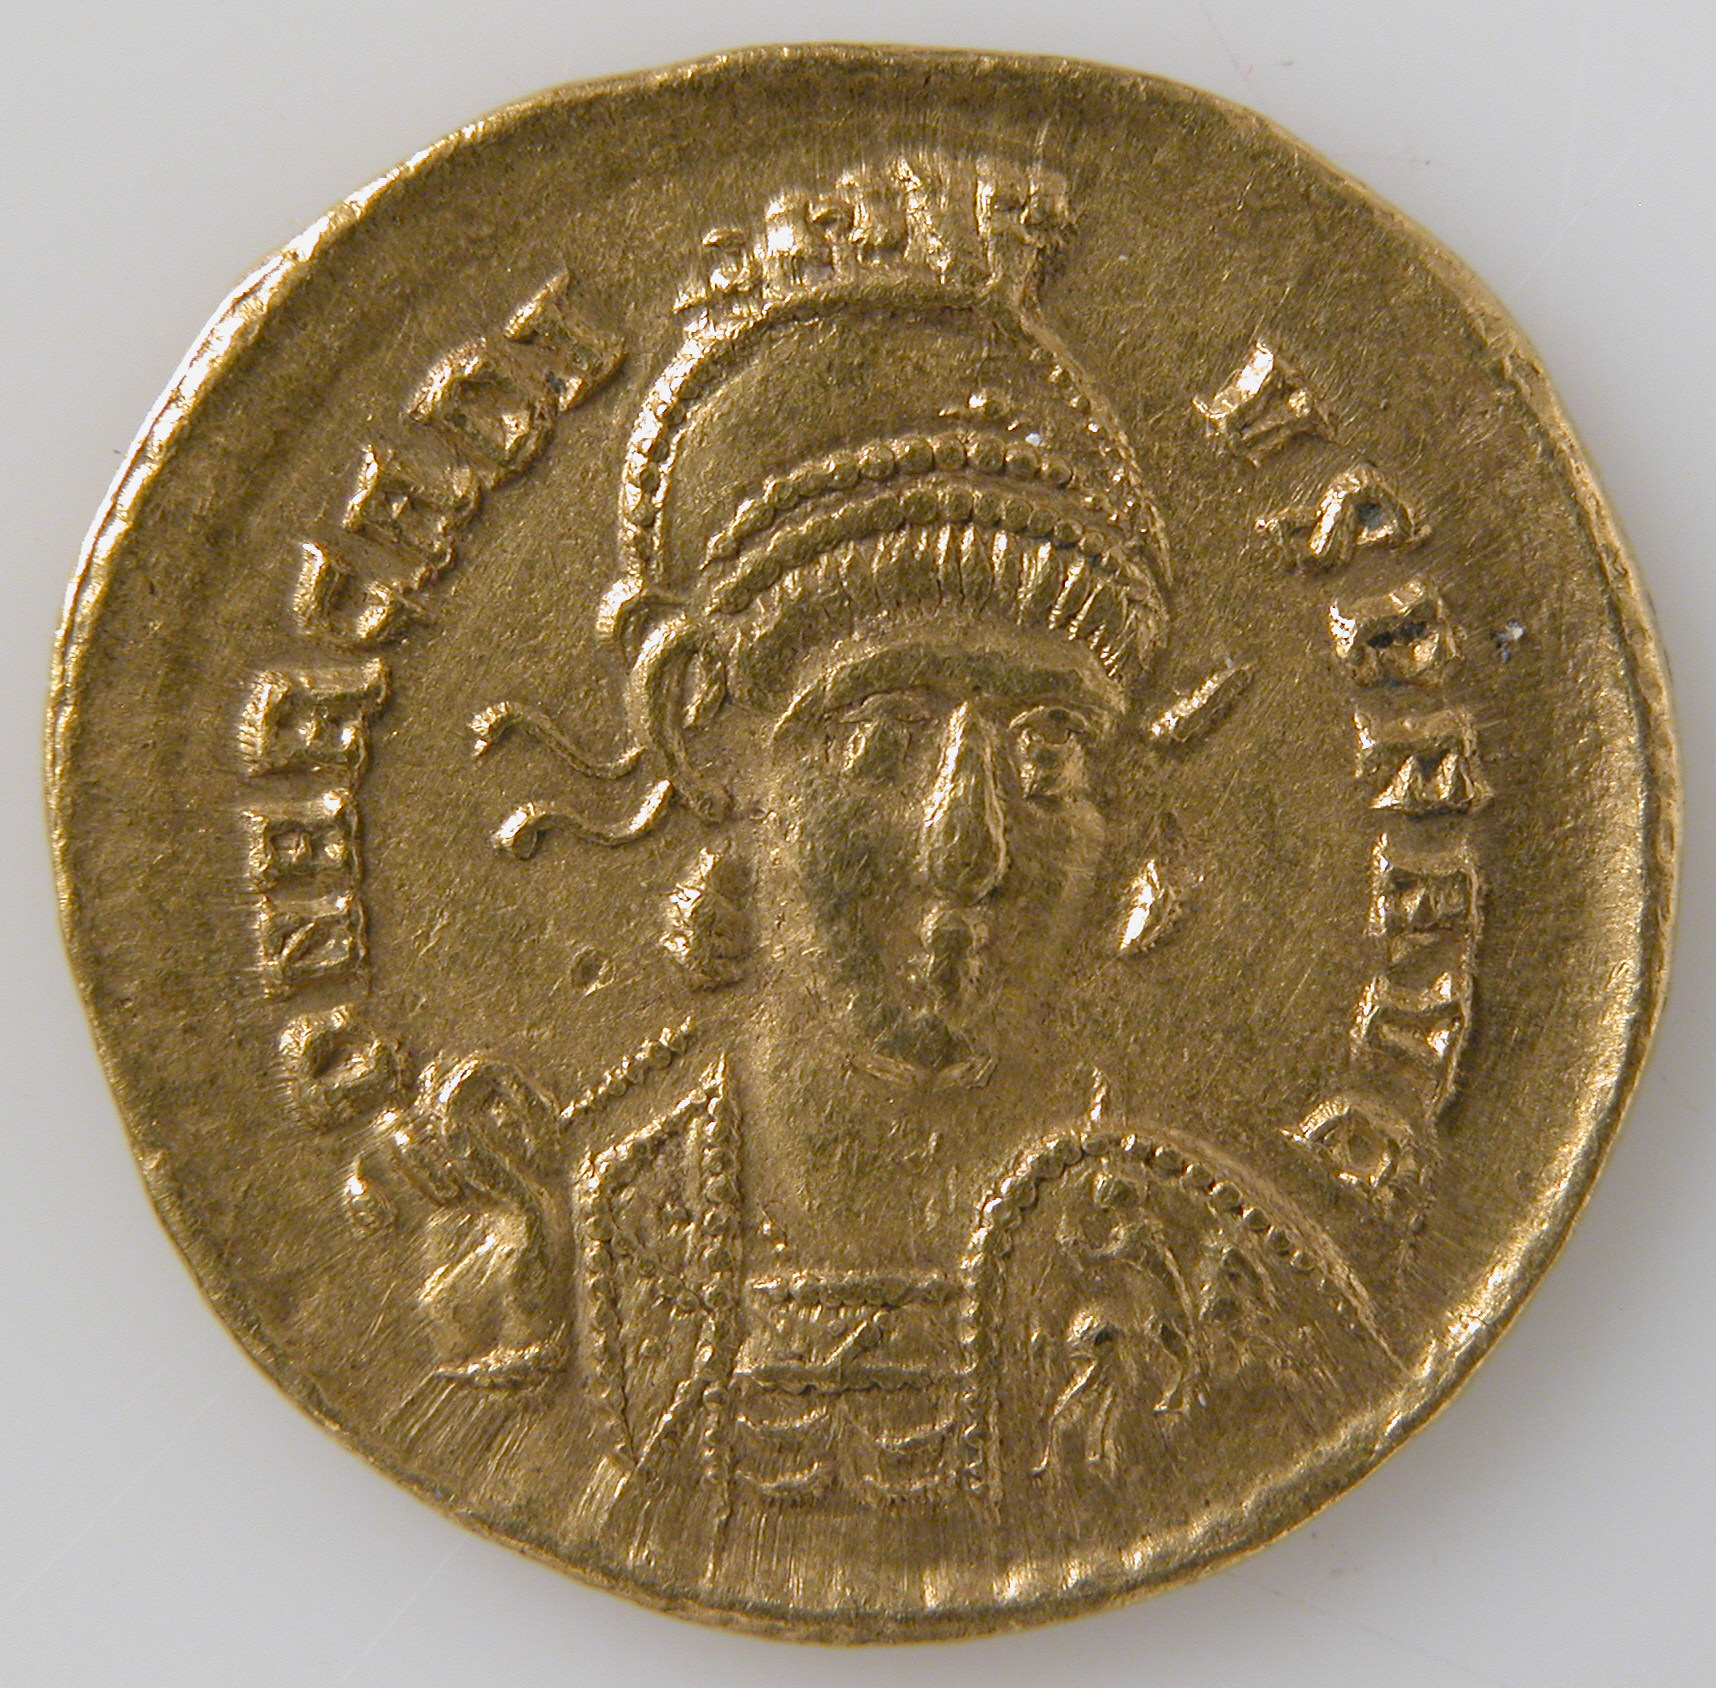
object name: solidus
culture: byzantine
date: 396-408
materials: gold